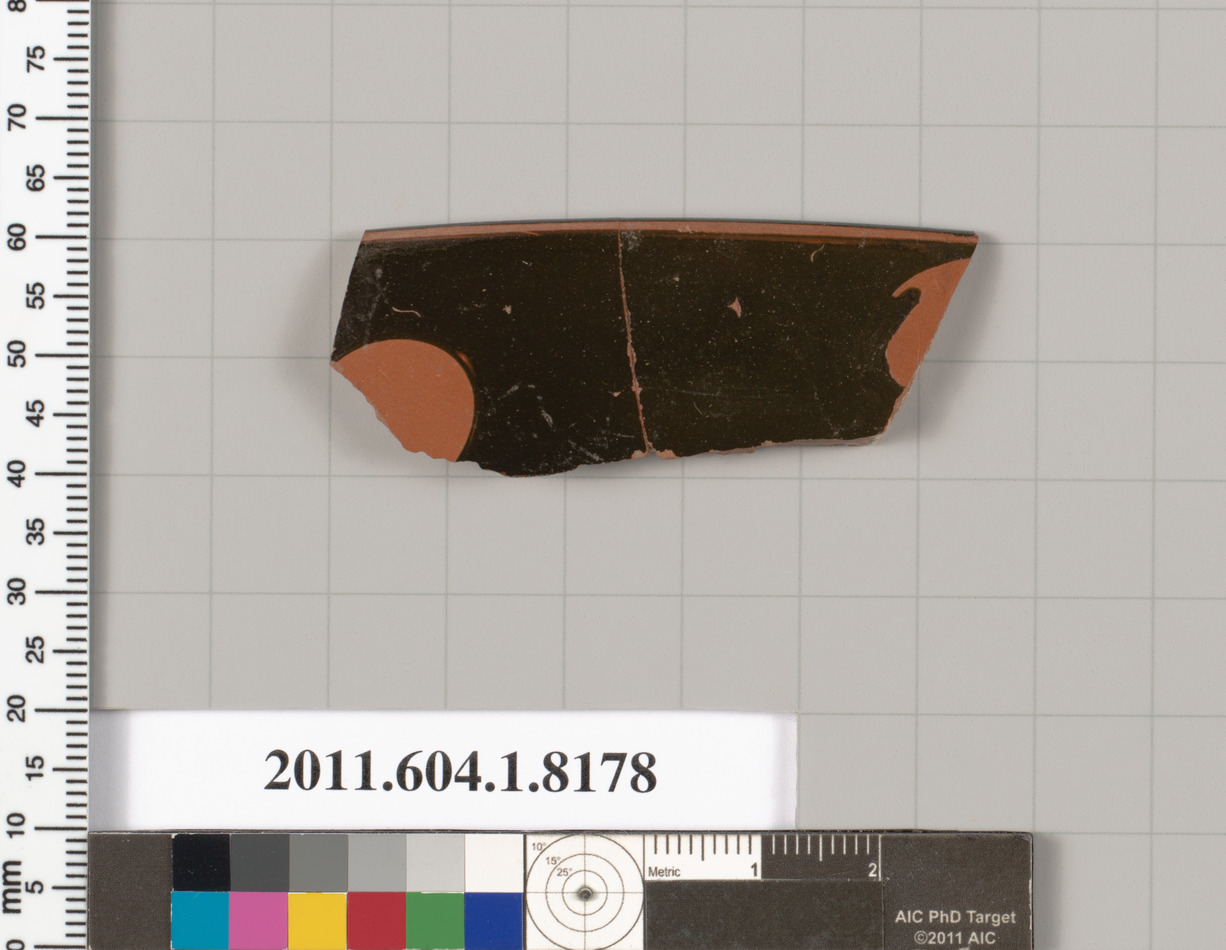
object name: kylix fragment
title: Terracotta rim fragment of a kylix (drinking cup)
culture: greek, attic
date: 520-510 BCE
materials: terracotta